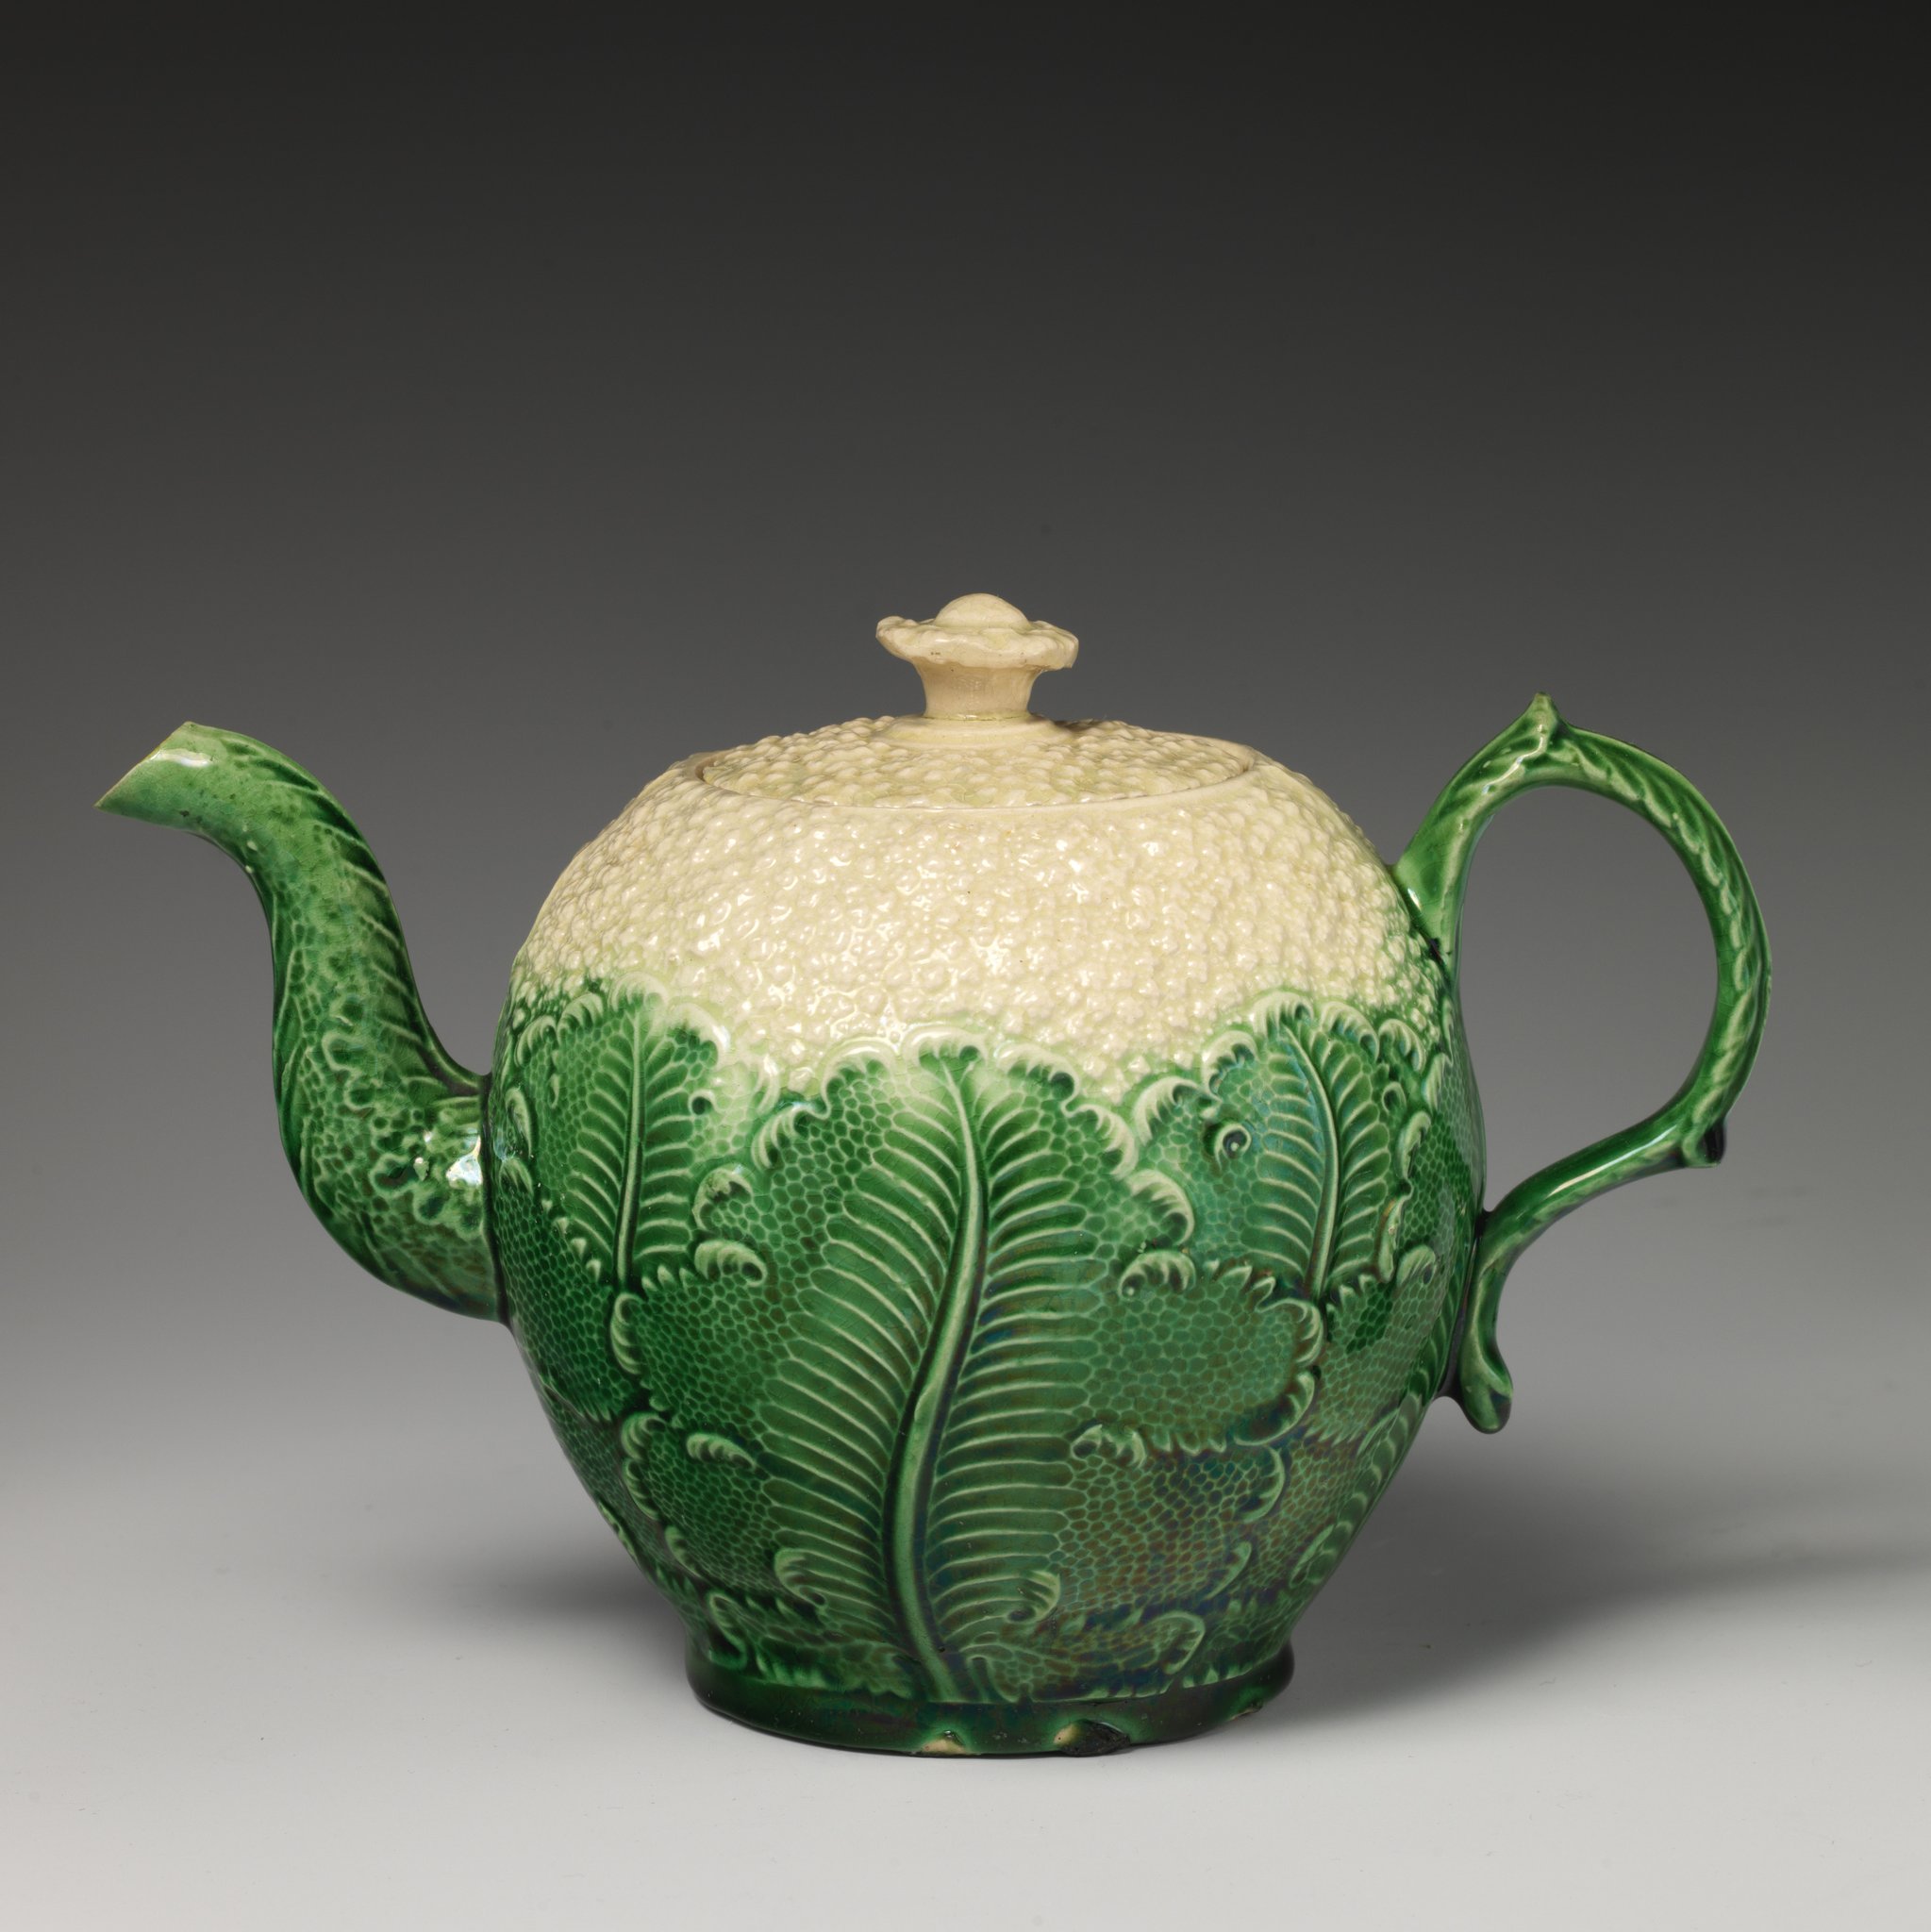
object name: teapot with cover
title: Teapot in the form of a cauliflower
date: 1755-1770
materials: earthenware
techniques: glazing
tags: leaves